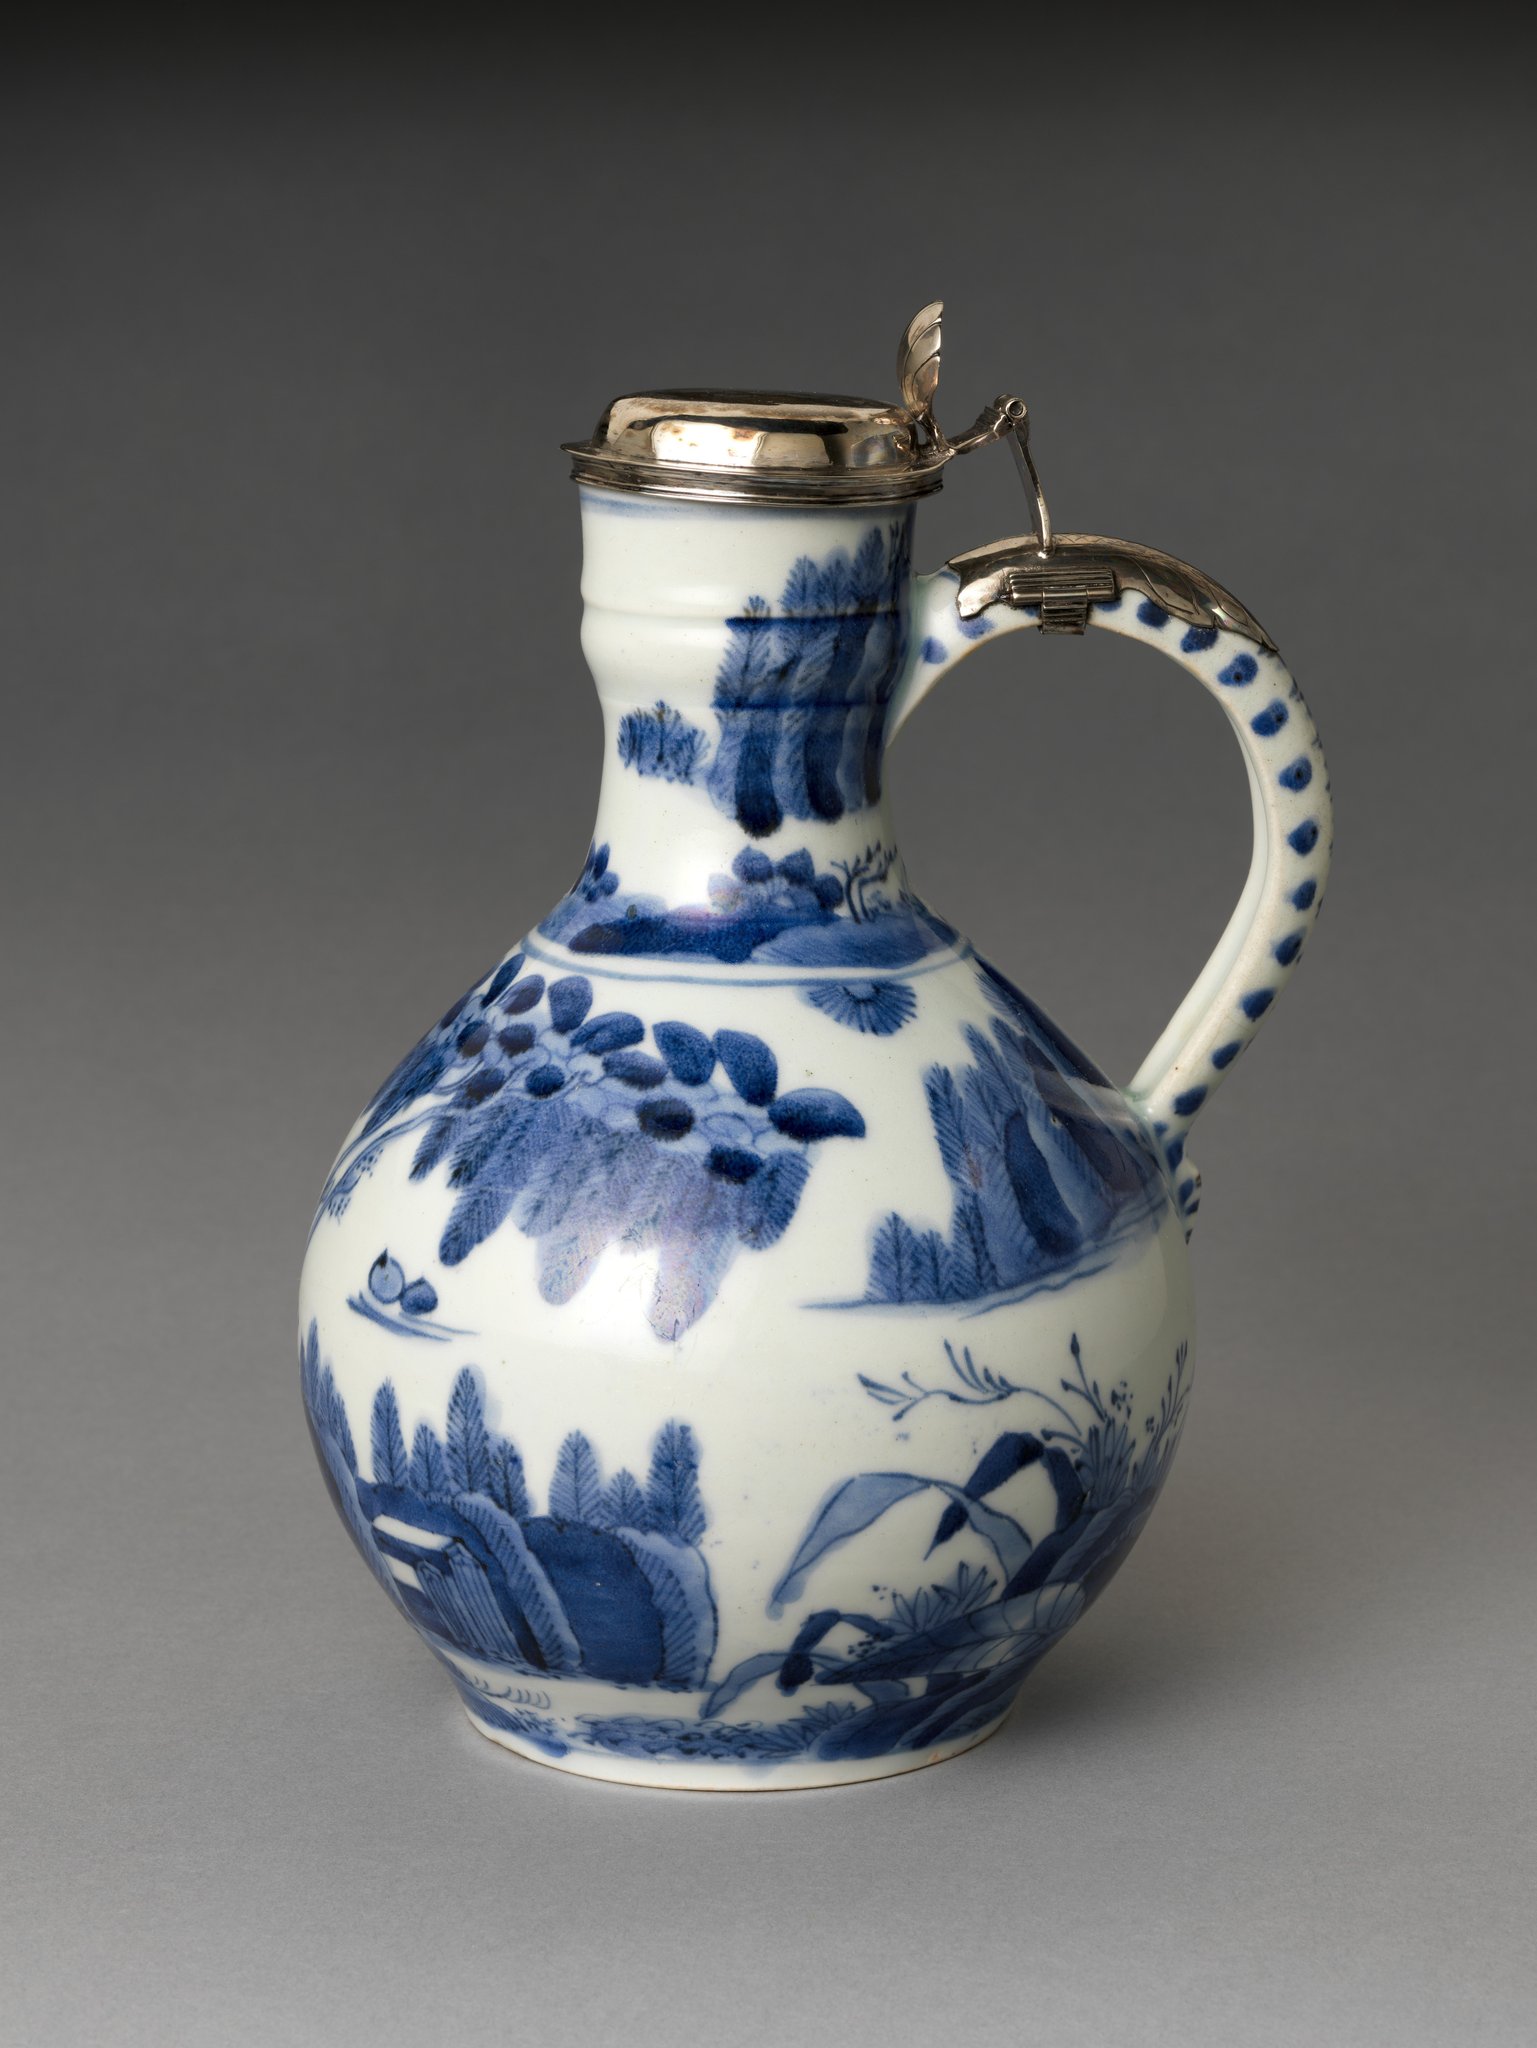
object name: ewer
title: Ewer with Figures in Landscape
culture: japanese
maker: adrian brandt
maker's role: artist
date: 1660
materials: cobalt, glaze, porcelain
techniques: painting